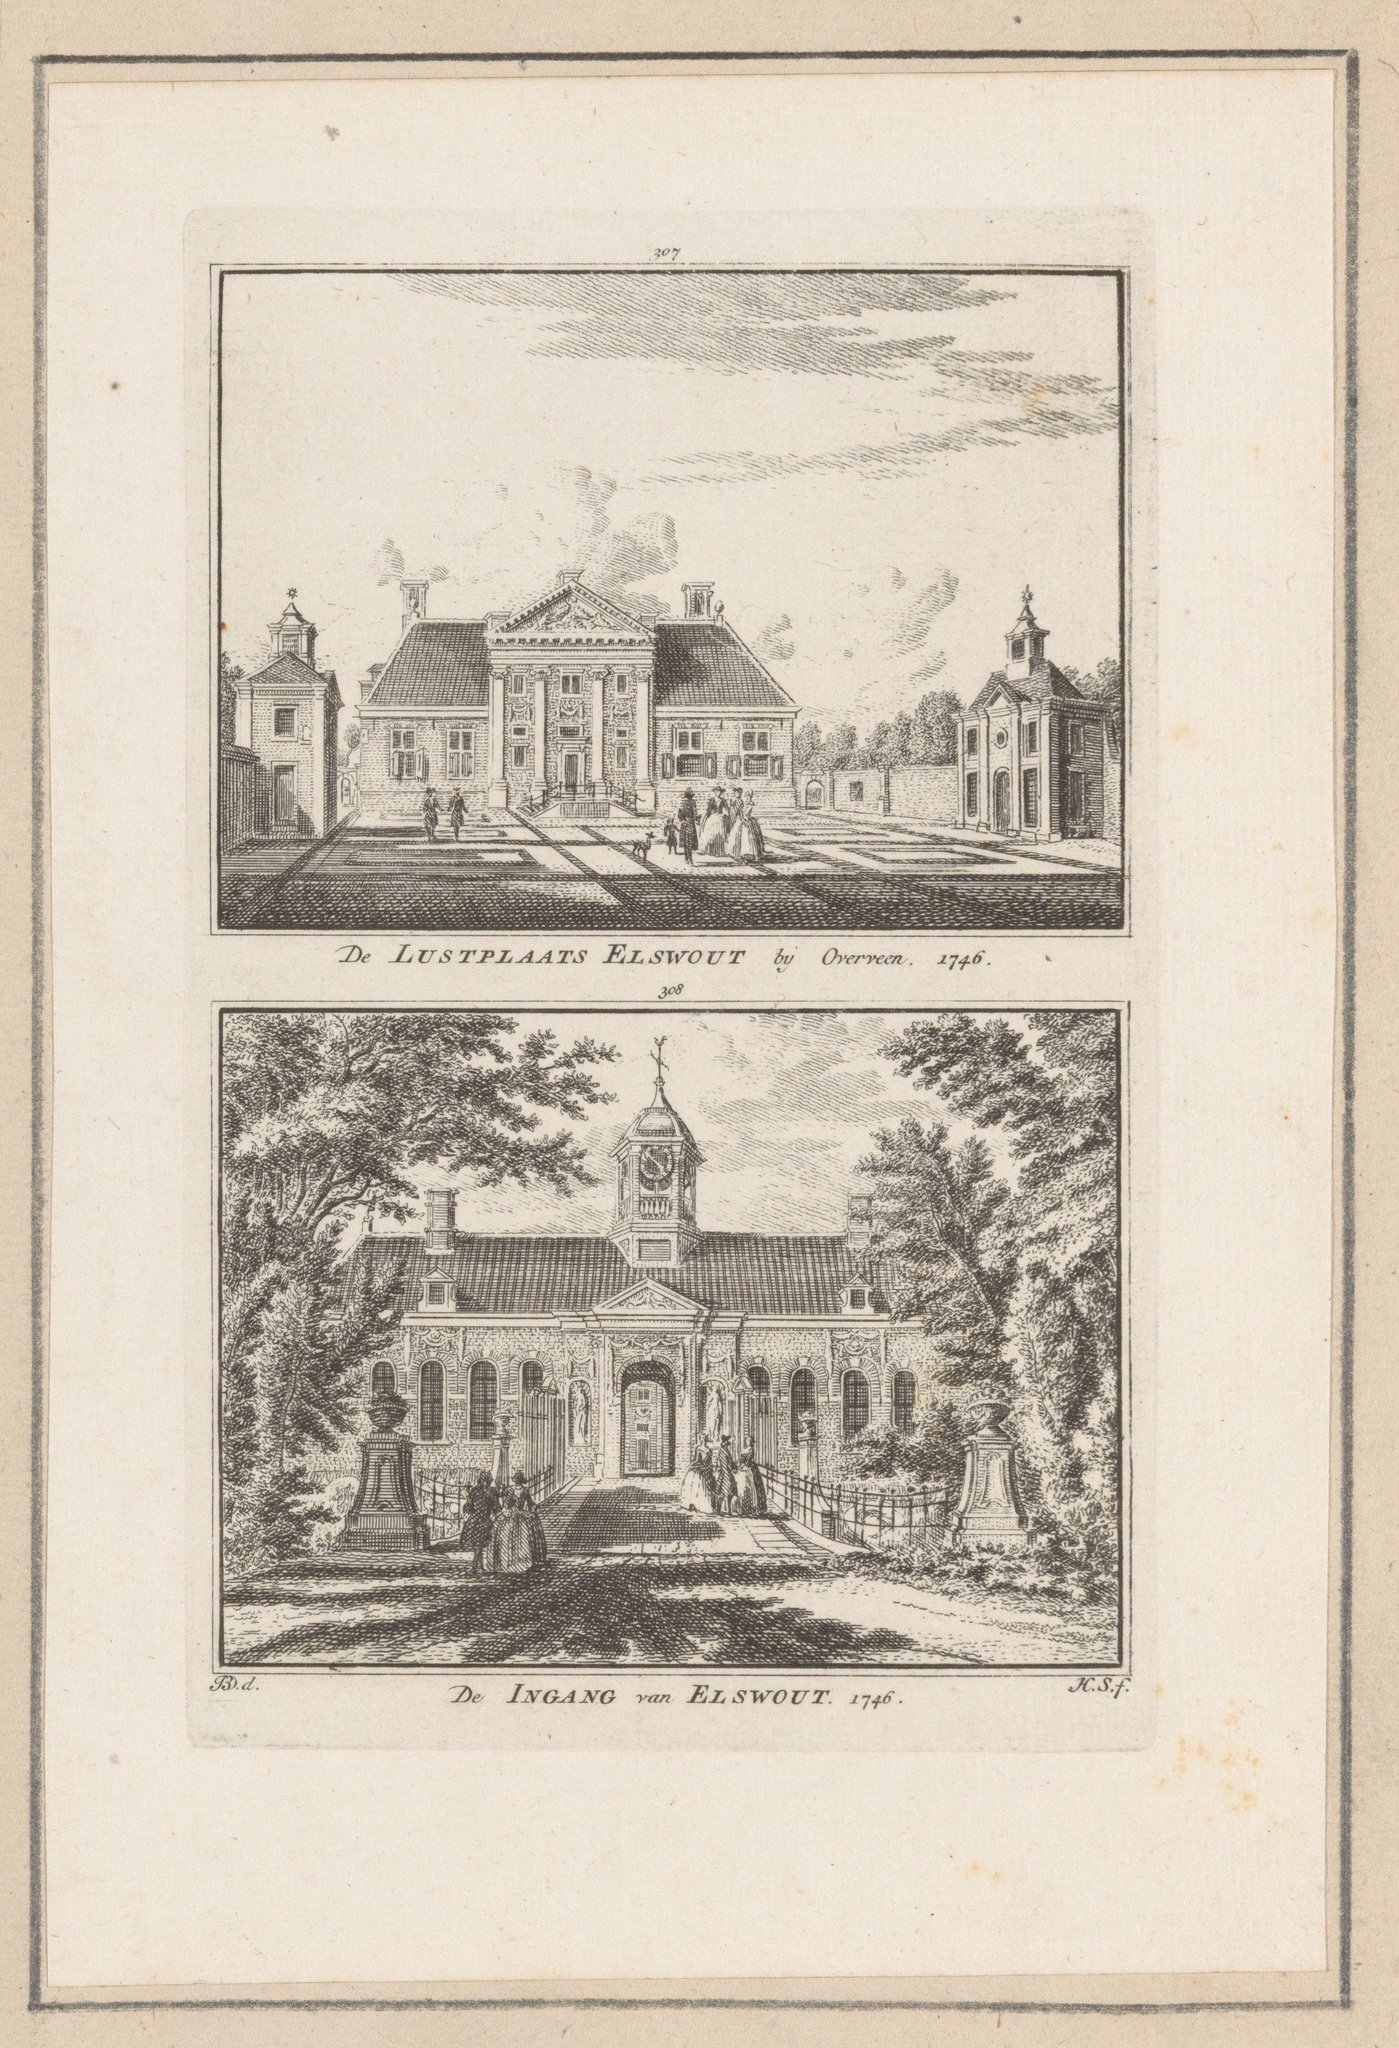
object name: book illustration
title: Twee gezichten op Elswout, 1746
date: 1752-1792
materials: paper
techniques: engraving, etching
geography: haarlem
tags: castle, gate, entrance, bridge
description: Prent ook gebruikt in: Het verheerlykt Nederland of kabinet van hedendaagsche gezigten van steden, dorpen (…). 9 delen. Amsterdam: Isaak Tirion en weduwe Isaak Tirion, 1745-1774, dl. 4 (1752), ill. 307 en 308. Of in: Nederlandsche tafereelen; of eene keurige verzameling van negen honderd fraaije gezigten van steden, dorpen, sloten, oudheden (….). 9 delen. Amsterdam: Jan de Groot, 1792, dl. 4, ill. 307 en 308. Uit welke druk het huidige exemplaar precies komt is niet na te gaan.